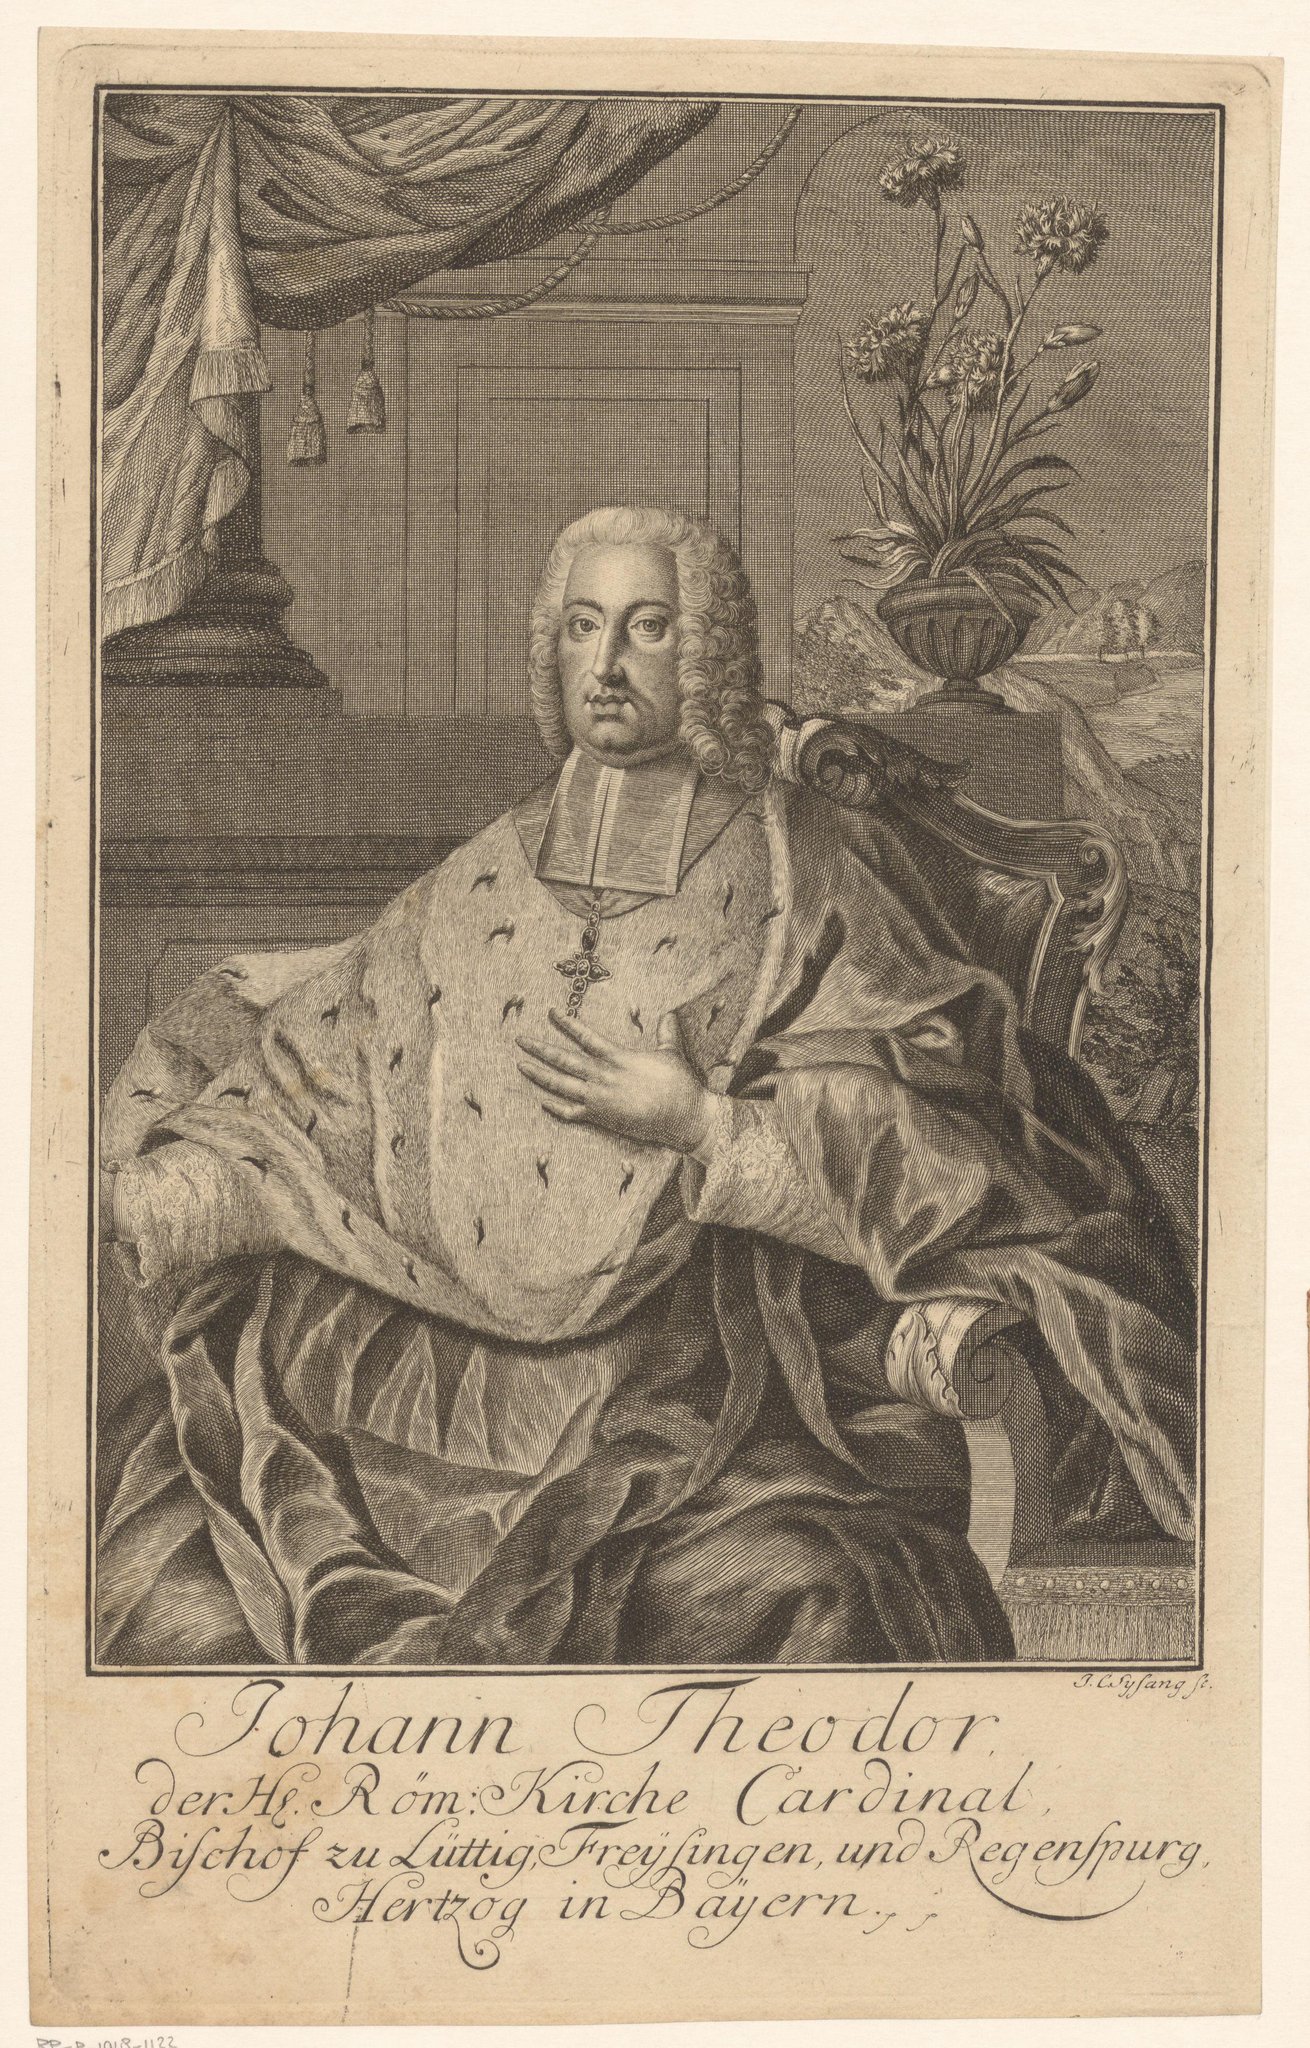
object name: print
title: Portret van Johann Theodor von Bayern, bisschop van Regensburg en Luik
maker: johann christoph sysang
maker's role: print maker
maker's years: 1703-1757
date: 1743-1757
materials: paper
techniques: engraving, etching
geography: leipzig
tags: liège, cardinal, historical persons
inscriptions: collector's mark: Lugt 2228